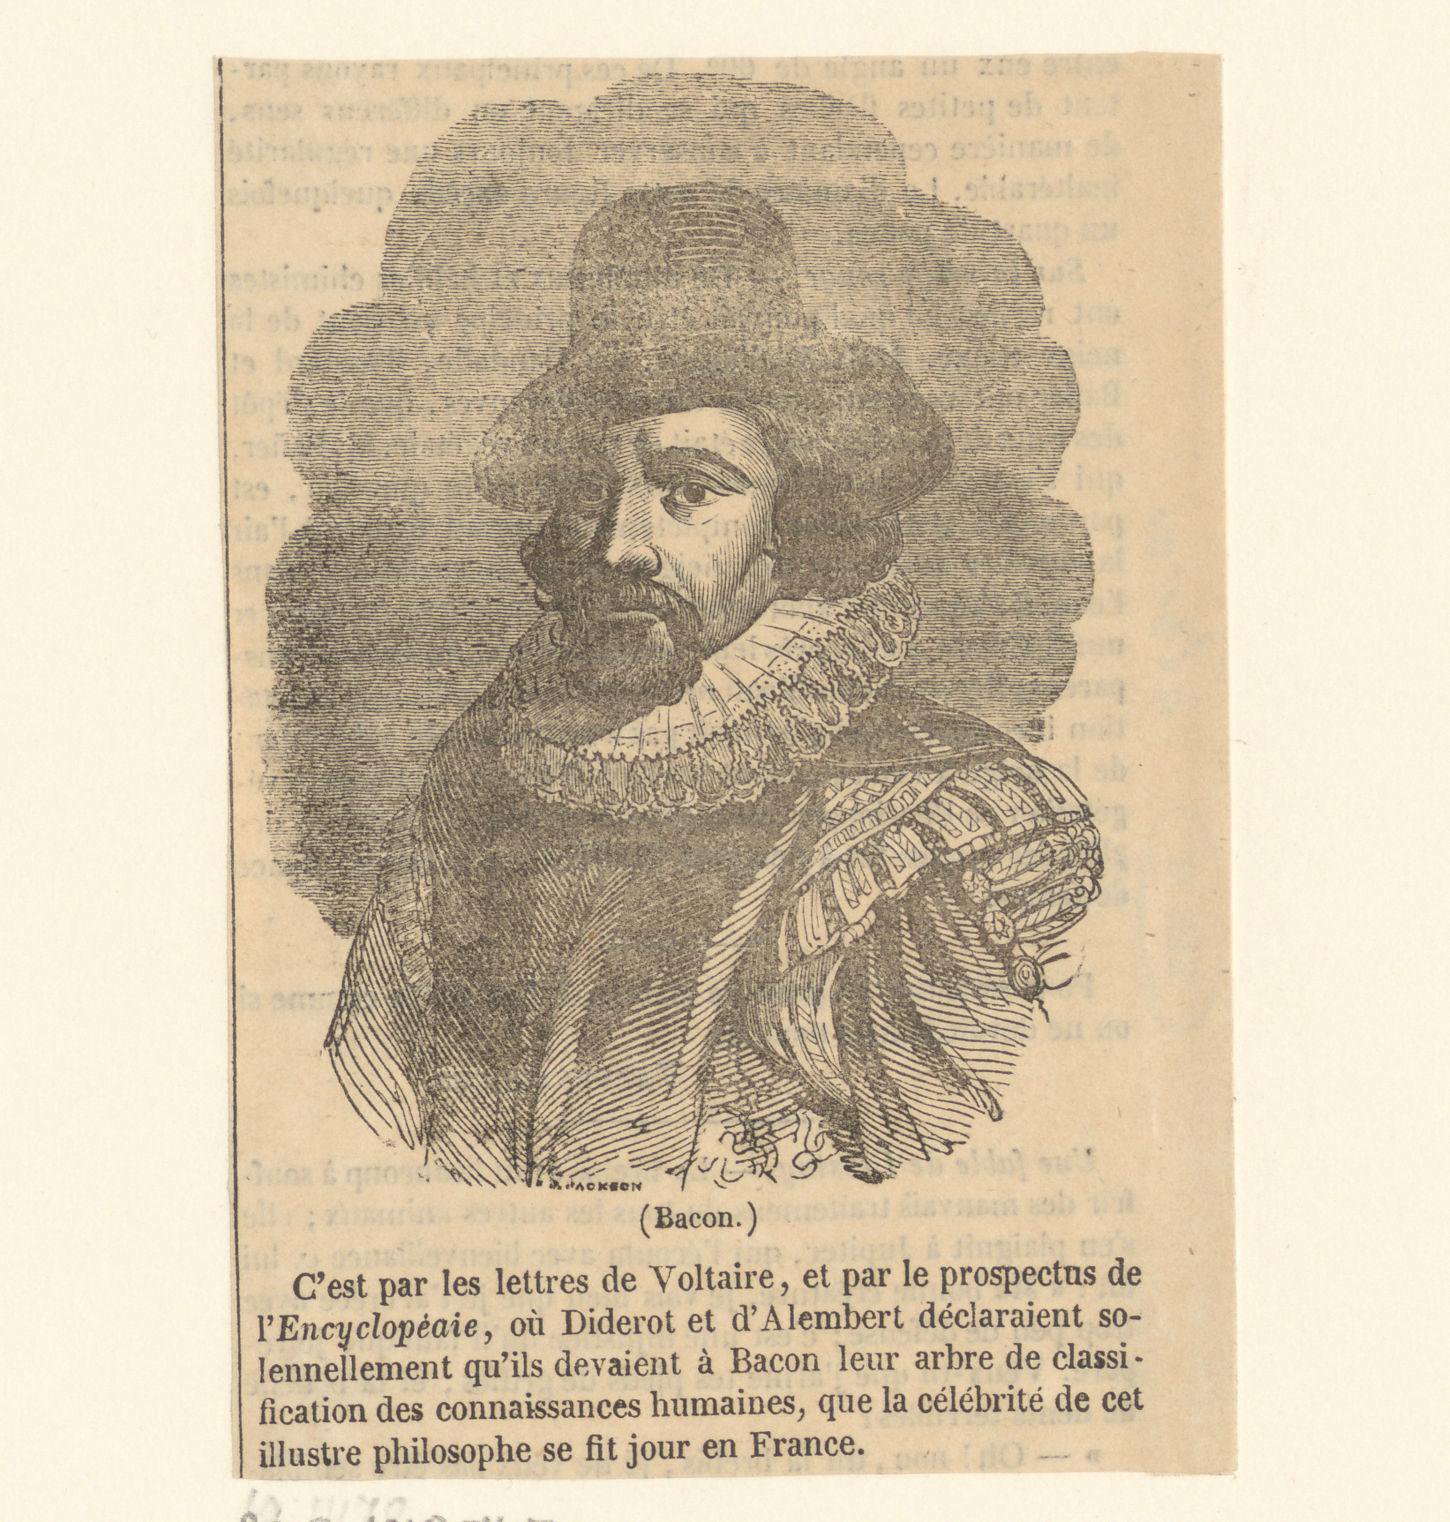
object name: print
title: Portret van Francis Bacon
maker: mason jackson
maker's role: print maker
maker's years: 1819-1903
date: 1829-1903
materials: paper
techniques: letterpress printing, engraving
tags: london, adult man, historical persons